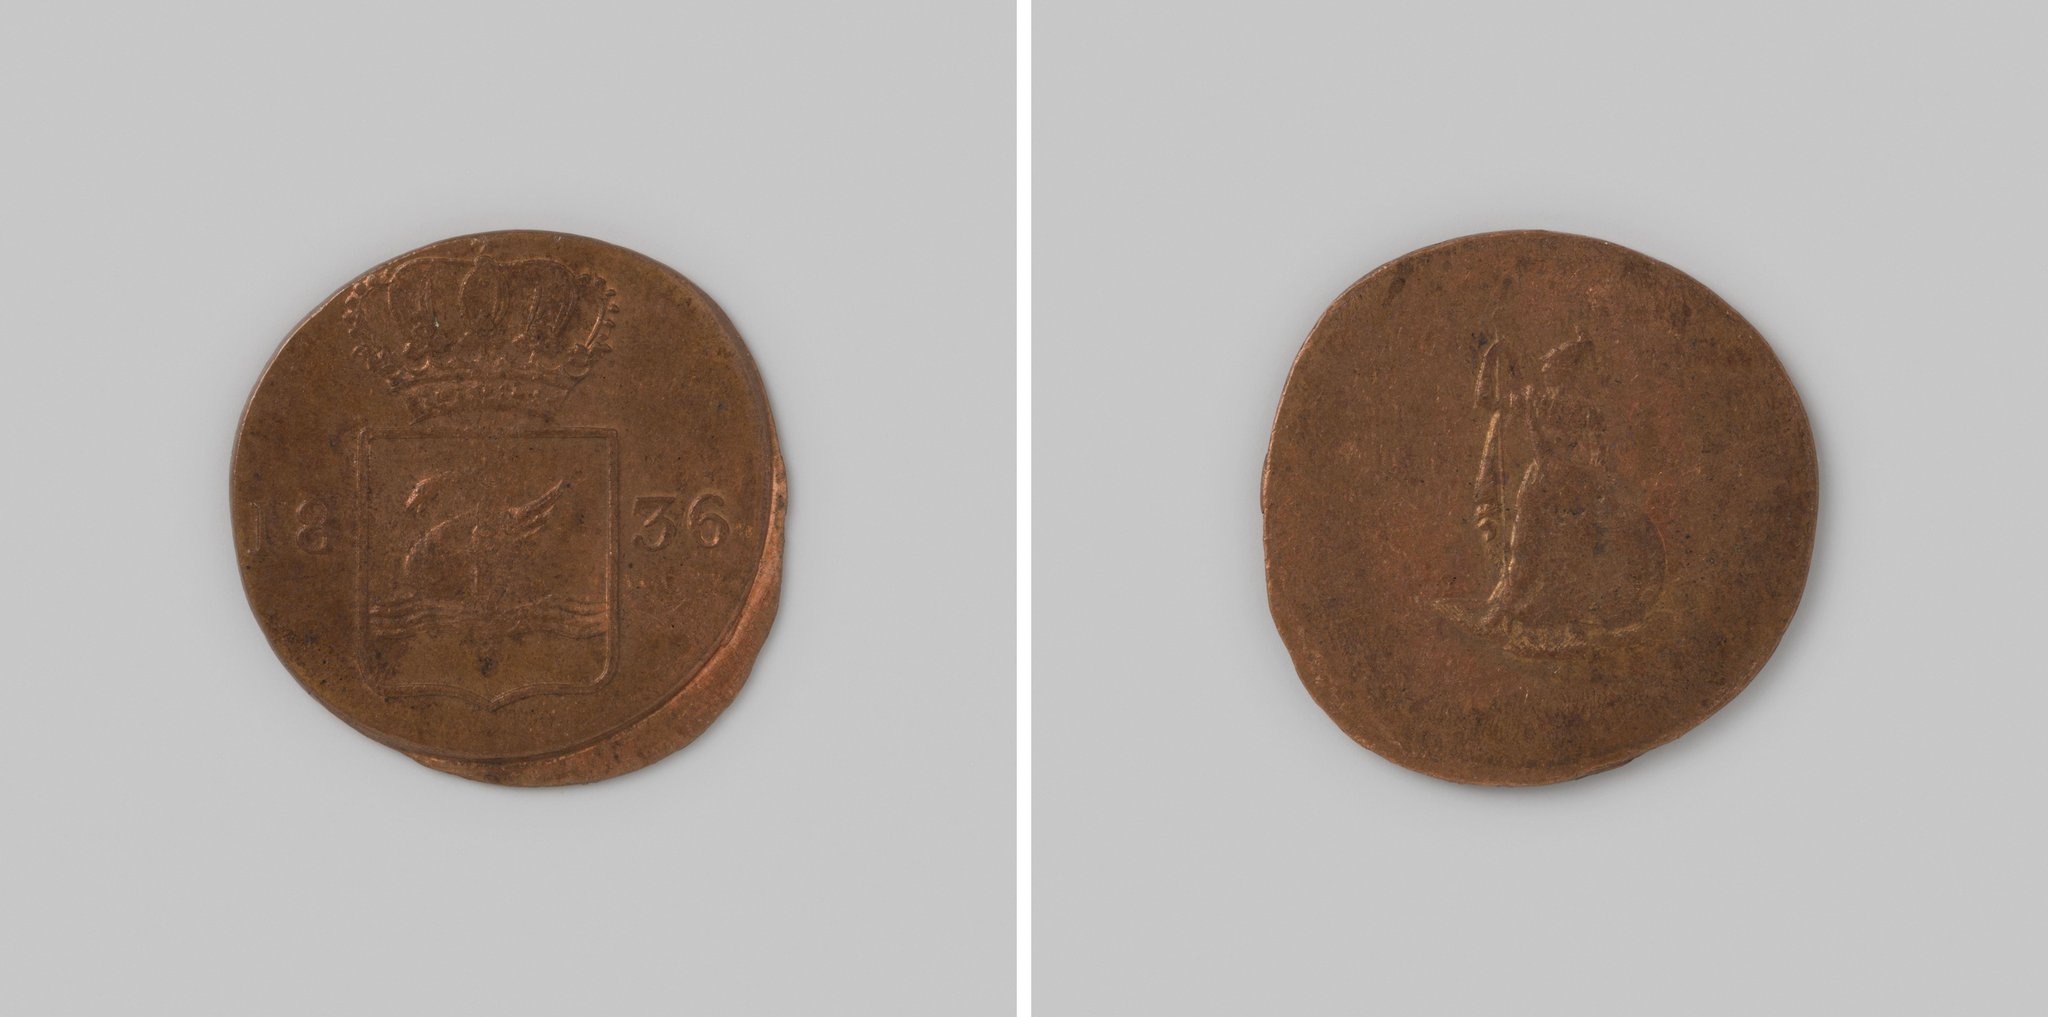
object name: coin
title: Nederlands Indië, zwaantjesduit,1836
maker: Anonymous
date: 1836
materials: copper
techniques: striking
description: Koperen proefmunt. Voorzijde: tussen jaartal gekroond wapenschild, waarin zwaan. Keerzijde: Pallas-figuur. Gladde rand.